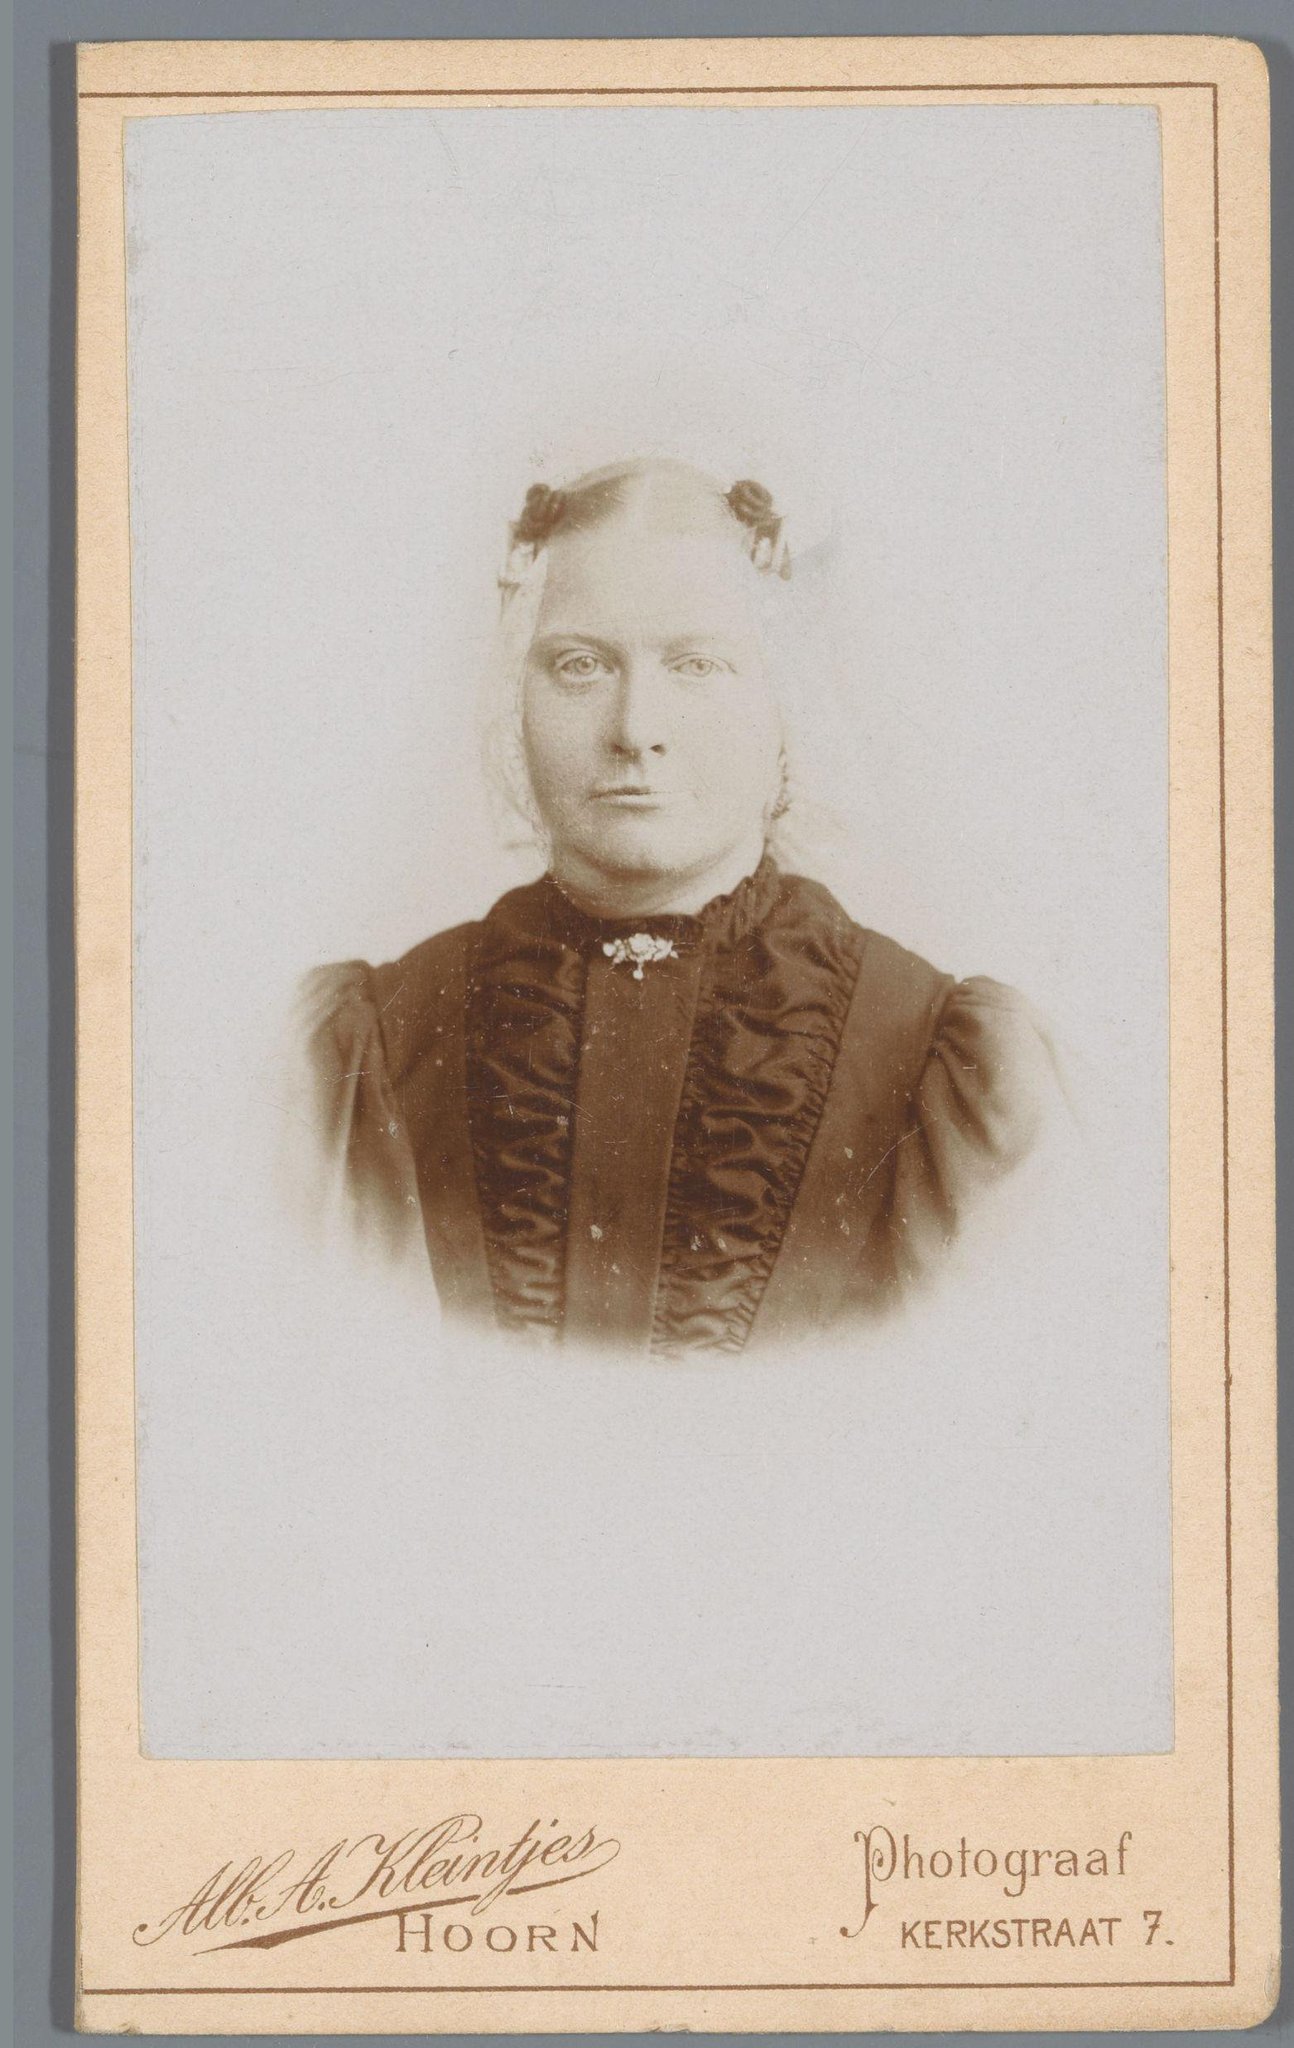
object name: photograph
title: Portret van Hiltje Bakker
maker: albert a. kleintjes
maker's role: fotograaf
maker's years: 1854-1942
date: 1883-1913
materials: cardboard, photographic support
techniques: collodion silver print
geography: hoorn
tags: historical persons - bb - woman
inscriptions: inscription: ‘Hiltje Bakker echtg./ P. Haan’, address: ‘Alb. A. Kleintjes/ HOORN/ Photograaf/ Kerkstraat 7’, inscription: ‘Alb. A. Kleintjes/ Photograaf/ Hoorn/ Kerkstraat/ 4e huis v. d. Kaasmarkt/ Nabestellingen en Vergrootingen van deze en andere/ Portretten kunnen ten allen tijde geleverd worden.’